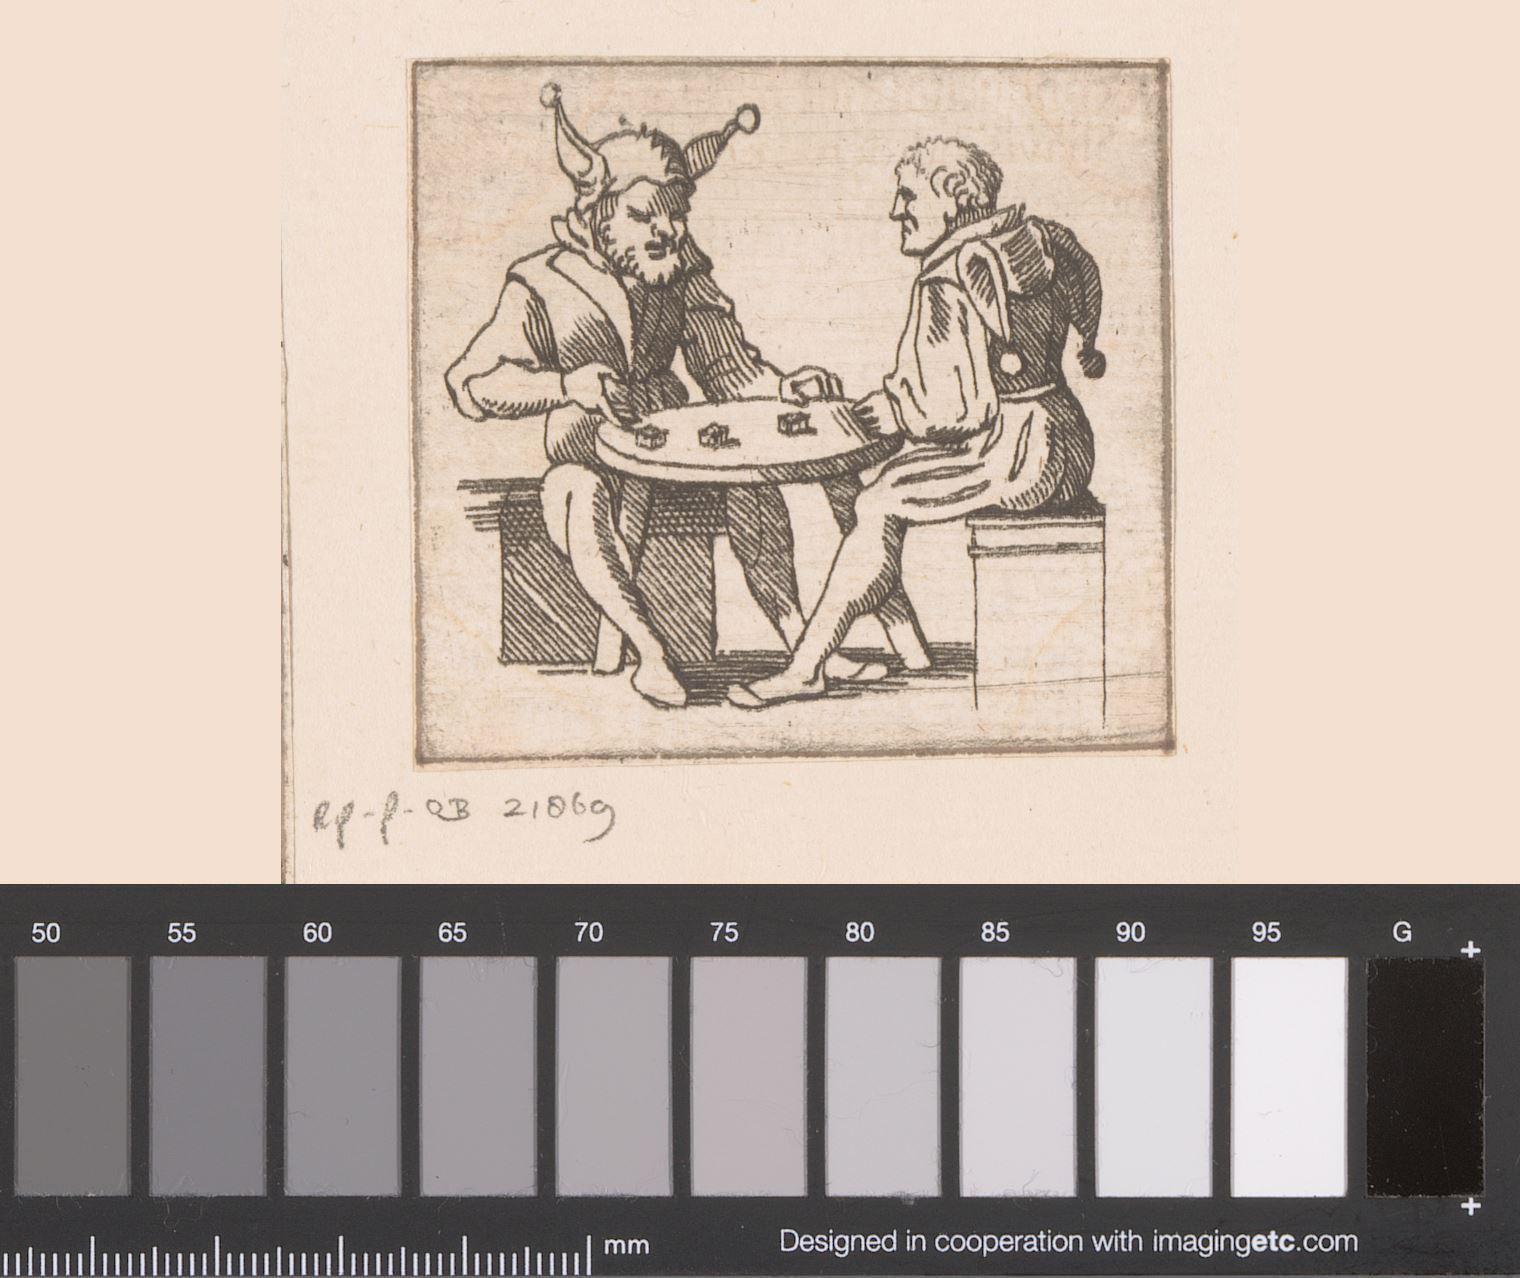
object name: book illustration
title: Illustraties uit de Lof der Zotheid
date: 1516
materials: paper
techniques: etching, letterpress printing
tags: rotterdam, desiderius erasmus, court jester, court fool, dice-games, folly, foolishness; 'pazzia', 'sciocchezza', 'stoltitia' (ripa)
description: Prent afkomstig uit: Erasmus, Desiderius. Morias enkomion (...). Bazel: Johann Rudolf Genath, 1676. De prenten hierin zijn naar tekeningen die Hans en Ambrosius Holbein maakten voor de theoloog Oswald Myconius in diens uitgave van de Moriae encomium (Lof der Zotheid) van 1516.